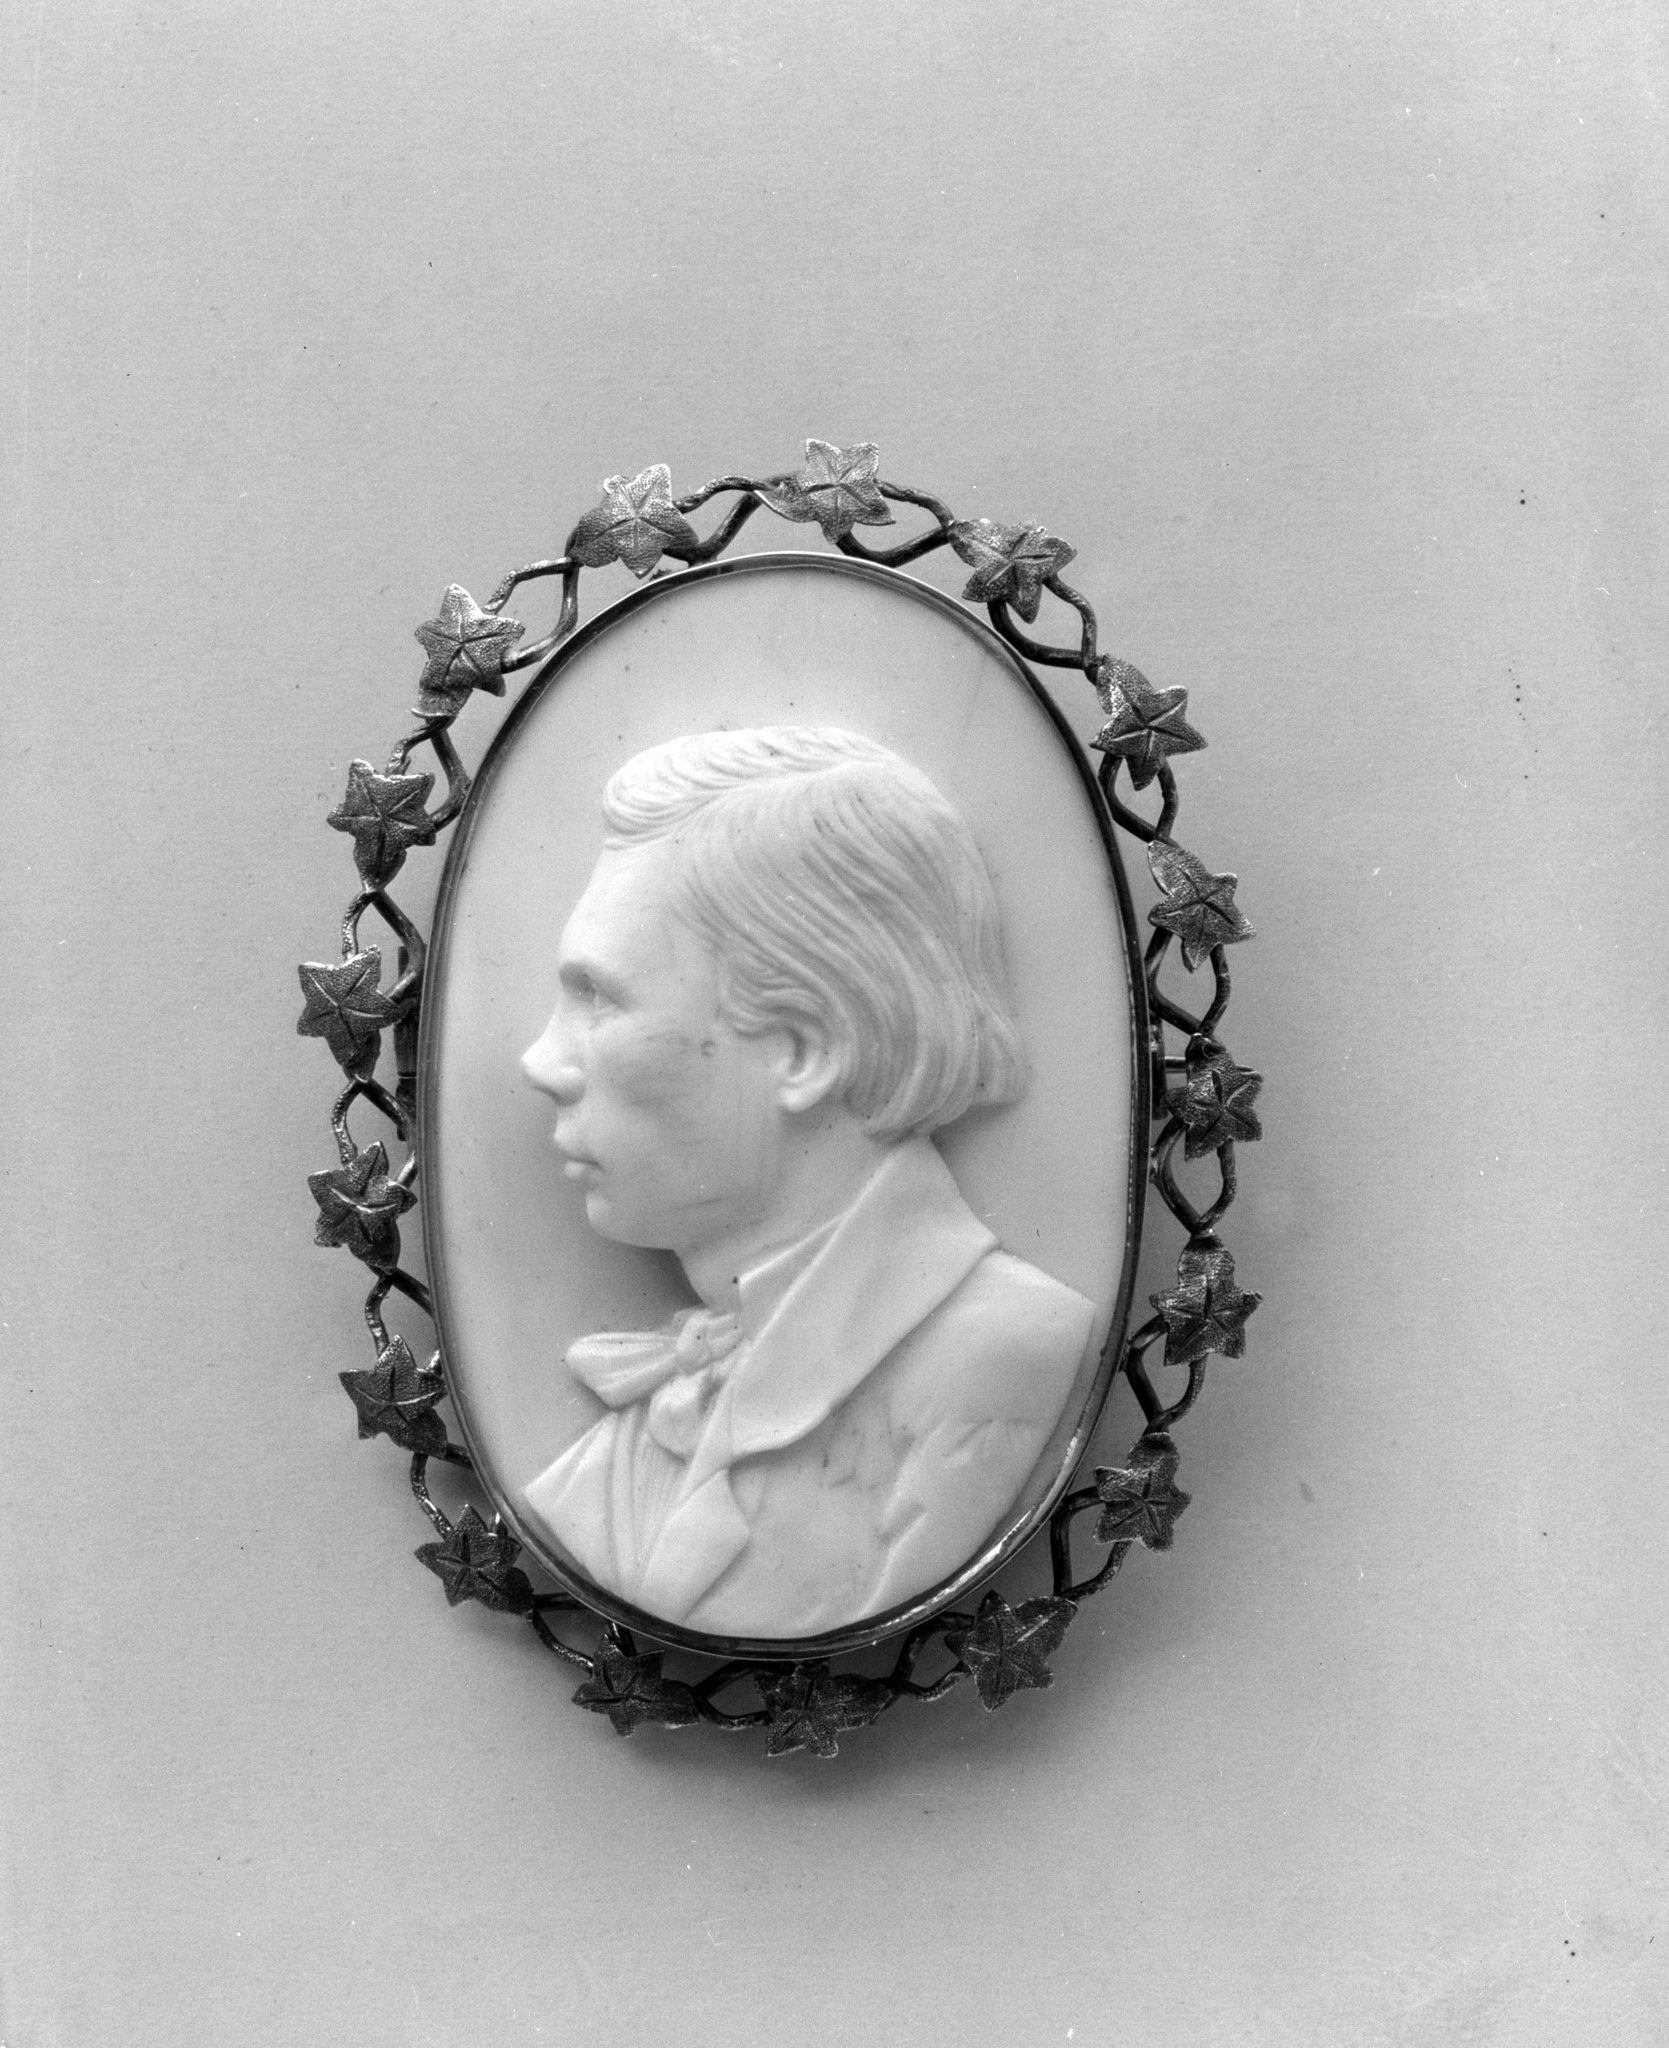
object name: brooch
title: Cameo Portrait of Frederick Marshall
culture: american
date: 1855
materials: gold, shell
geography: united states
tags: men,portraits,profiles